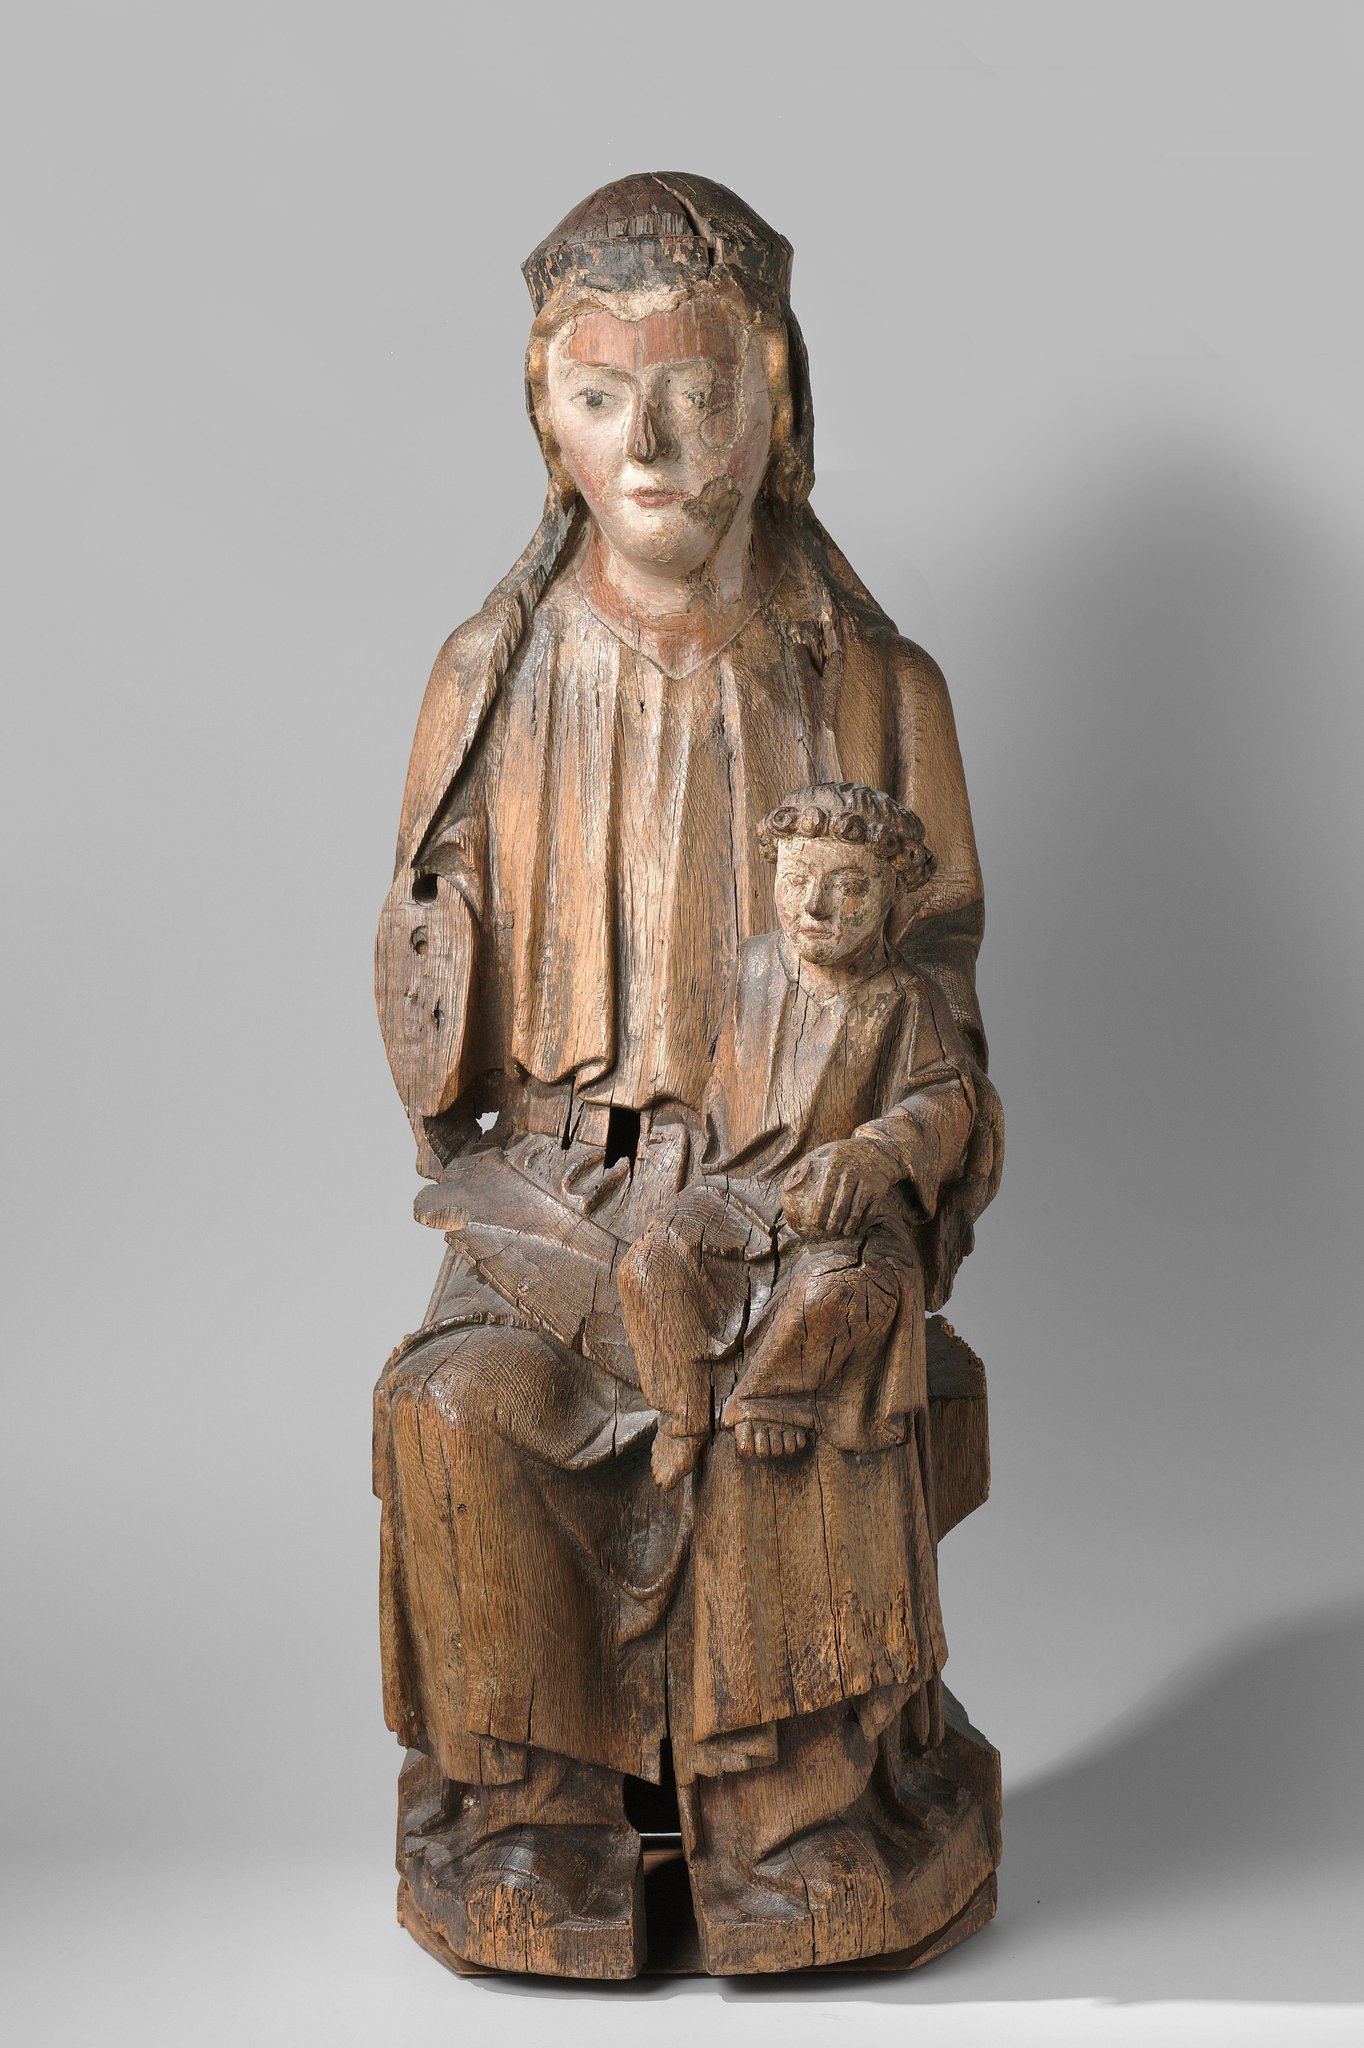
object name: sculpture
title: Virgin and Child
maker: Anonymous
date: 1250-1260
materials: wood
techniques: carving, gilding, polychromy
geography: meuse area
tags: 'sedes sapientiae'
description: The Virgin sits with the Christ Child on her lap. Not only is she the mother of Jesus, here she is also the sedes sapientiae (seat of wisdom) – thus the throne on which is seated Christ, who represents divine wisdom. Together with the crucified Christ, this was one of the earliest subjects of free-standing sculpture in the Middle Ages.